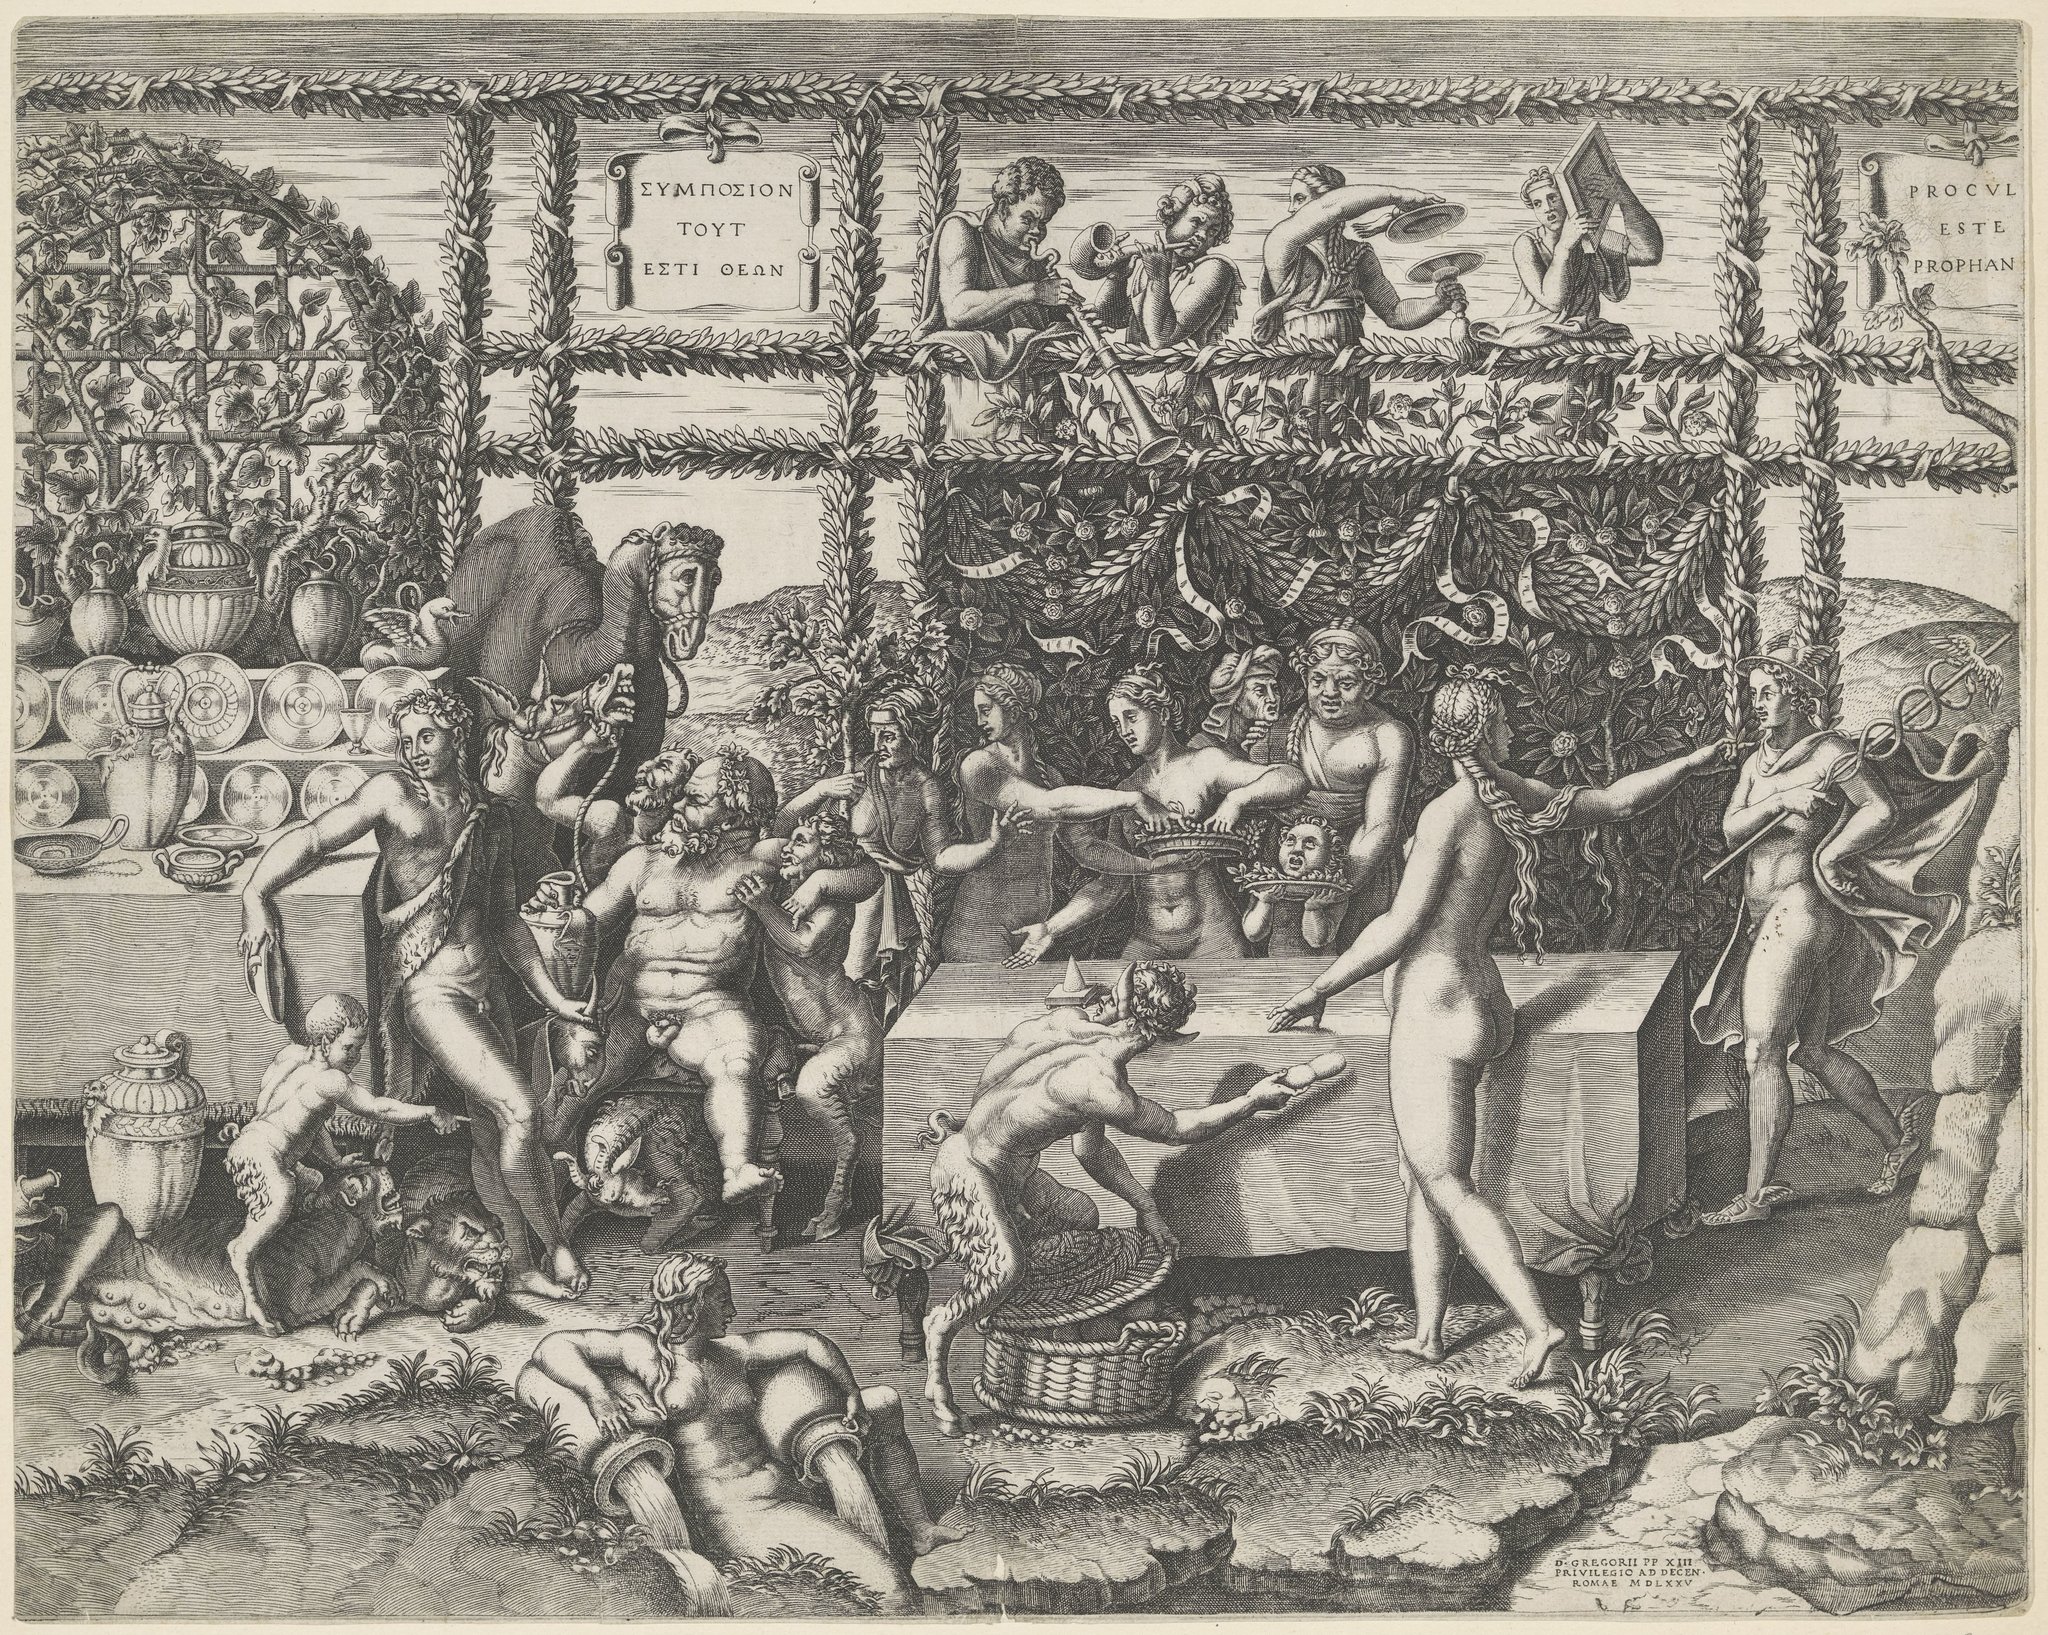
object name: print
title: Huwelijksfeest van Amor en Psyche (midden deel)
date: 1575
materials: paper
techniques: engraving, etching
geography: mantua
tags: marriage of cupid and psyche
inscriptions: collector's mark: Lugt 240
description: Verschillende mythologische figuren rond een tafel, zoals Mercurius en een sater. Daarboven vier muzikanten. Links een met luxe serviesgoed gedekte tafel die staat onder een baldakijn begroeid met druivenranken.